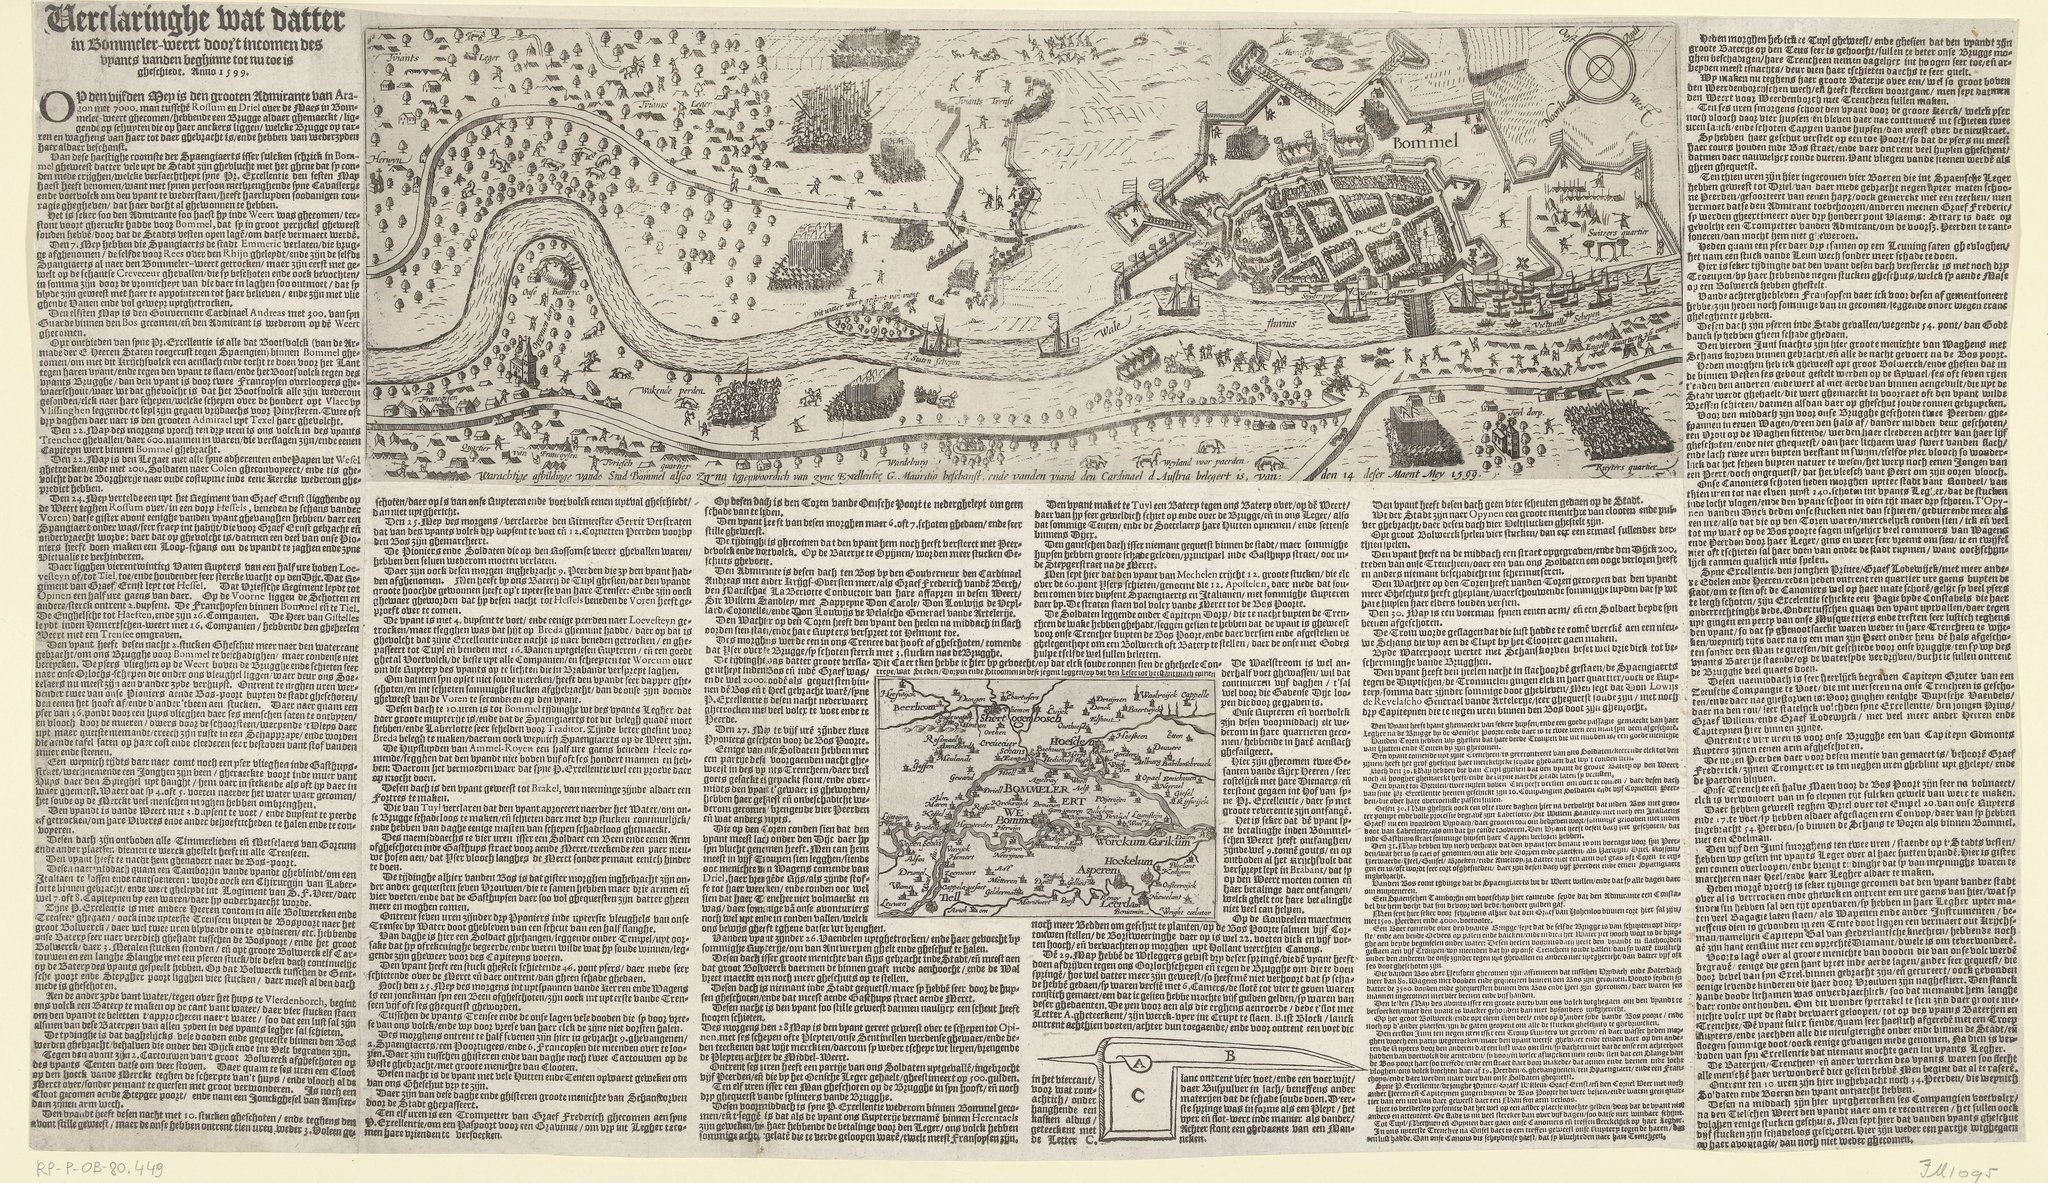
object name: print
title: Belegering van Zaltbommel en andere sterkten in de Bommelerwaard, 1599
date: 1599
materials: paper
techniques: etching, letterpress printing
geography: northern netherlands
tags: the hague, maurice (prince of orange), siege, position war, maps of cities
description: Nieuwsblad met een voorstelling van de belegering door de Spanjaarden onder Mendoza van Zaltbommel en andere sterkten in de Bommelerwaard in handen van het Staatse leger onder prins Maurits, begin mei - 4 juni 1599. Hierbij ook een kaartje van de Bommelerwaard en een afbeelding van een zogenaamde springer of fladdermijn. Geheel met 6 kolommen Nederlandse teksten met een beschrijving van het verloop van de strijd.